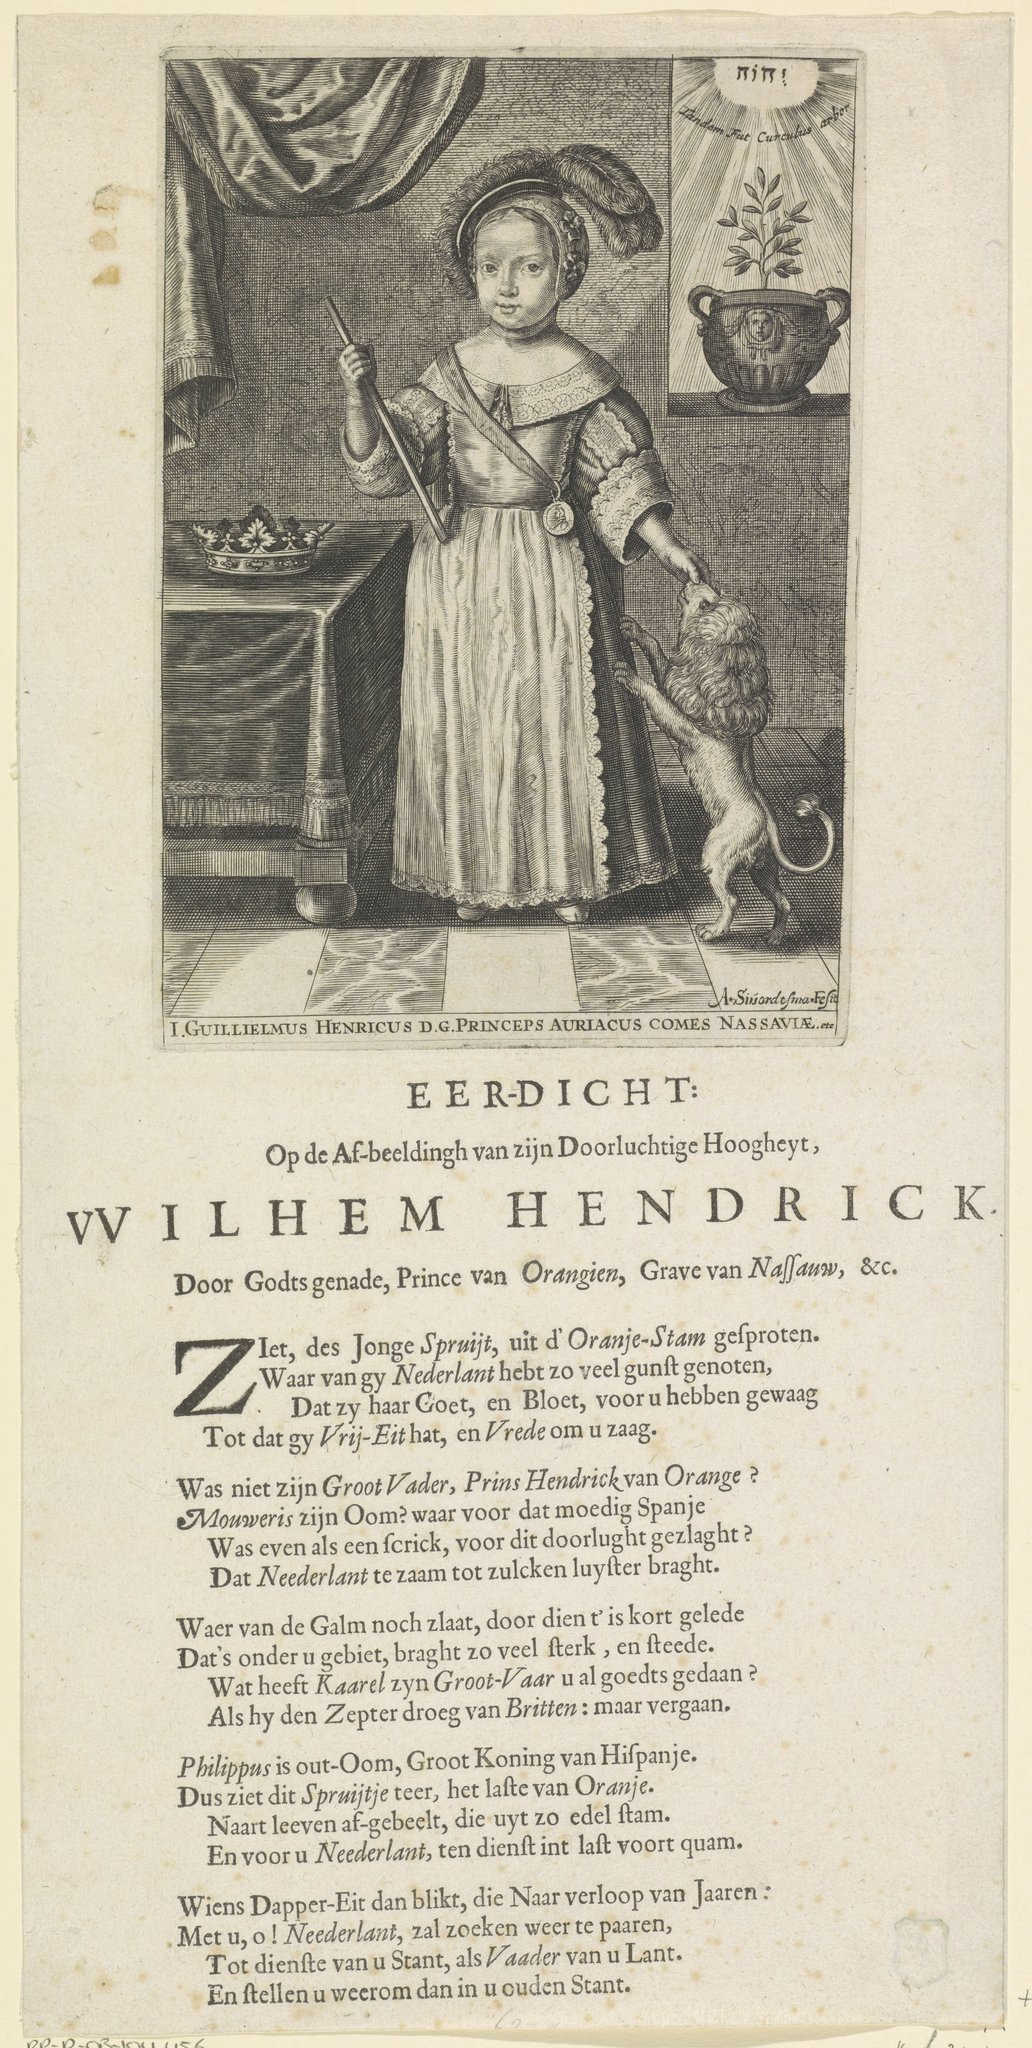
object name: print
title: Portret van Willem III, prins van Oranje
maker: anthonie heeres siverdtsma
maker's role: print maker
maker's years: 1625-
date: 1652-1662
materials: paper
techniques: engraving, letterpress printing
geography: amsterdam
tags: william iii (prince of orange and king of england, scotland, and ireland)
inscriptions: collector's mark: Lugt 963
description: Portret van Willem III als kind spelend met een hondje en staande bij een tafel waarop een kroon ligt. Rechts in een venster een pot met de oranjeboom waarop het goddelijk licht schijnt. In de marge een eenregelig Latijns onderschrift. Onder de prent een 'Eer-dicht: Op de Af-beeldingh van zijn Doorluchtige Hoogheyt, Wilhem Hendrick, door Godts genade, Prince van Orangien, Grave van Nassauw, &c.'.